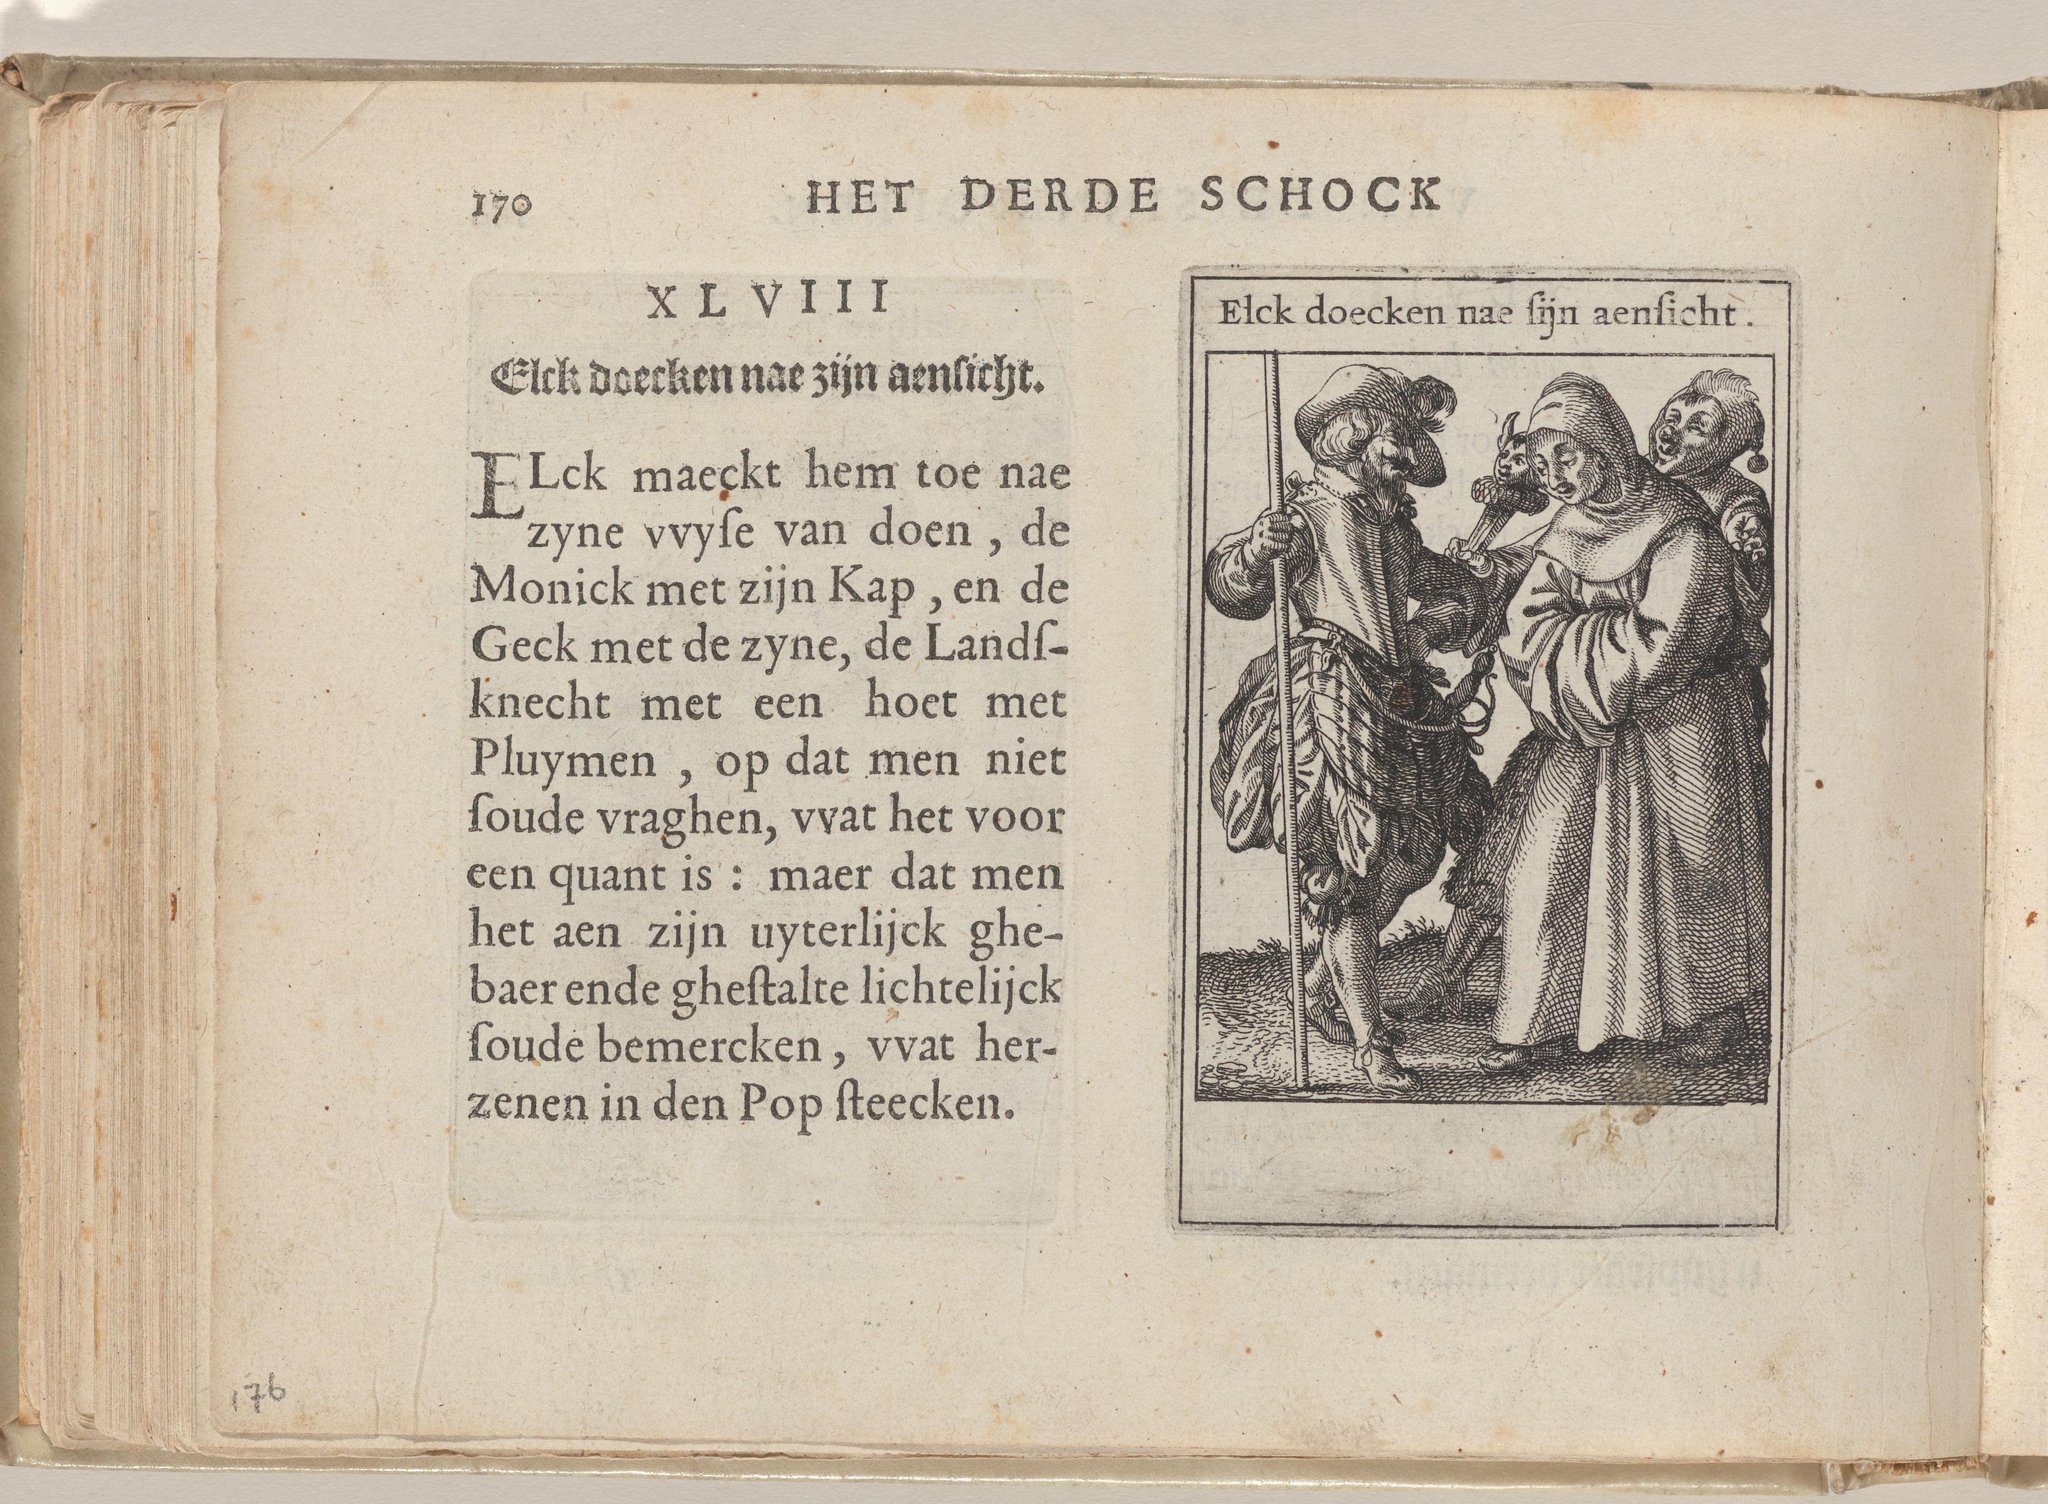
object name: print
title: XLVIII Elck doecken nae sijn aensicht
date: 1614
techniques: engraving, printing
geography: amsterdam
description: XLVIII Elck doecken nae sijn aensicht. Derde schok. Onderdeel van 'Sinnepoppen', R. Visscher, 1614.